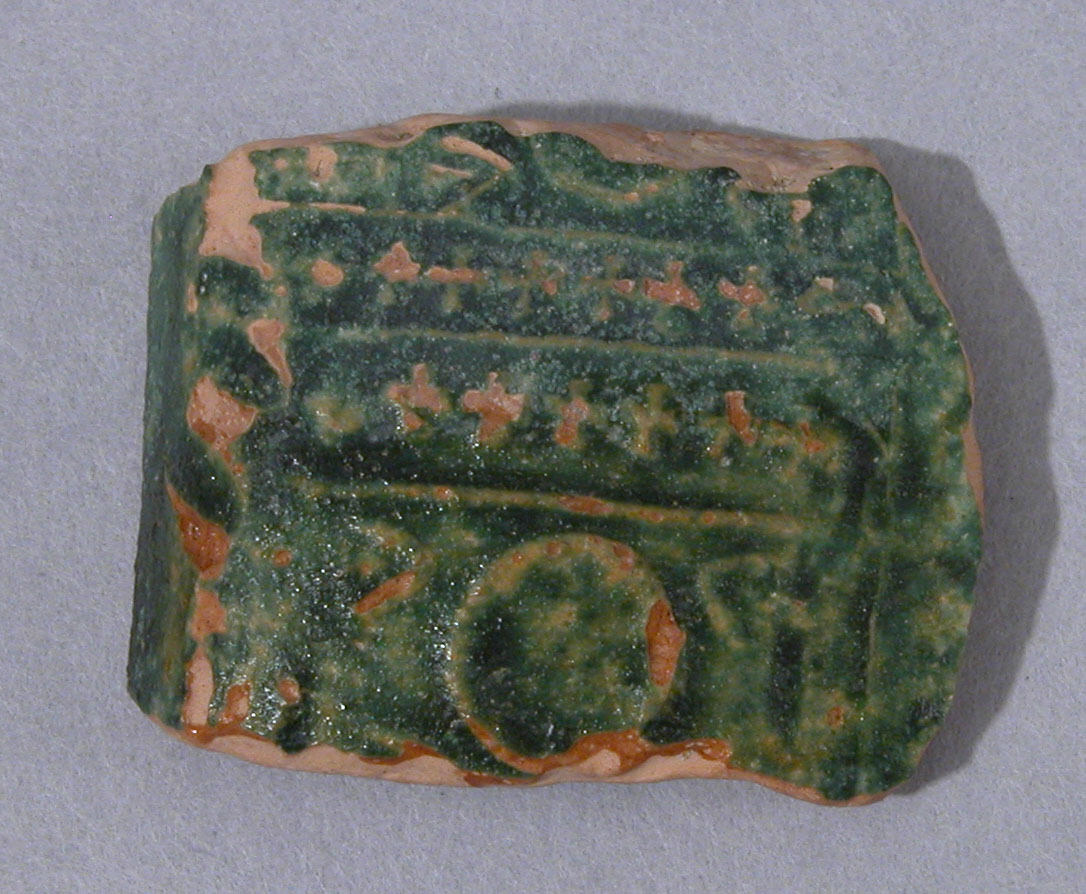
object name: fragment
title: Ceramic Fragment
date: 801-900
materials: earthenware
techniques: glazing, molding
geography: saudi arabia